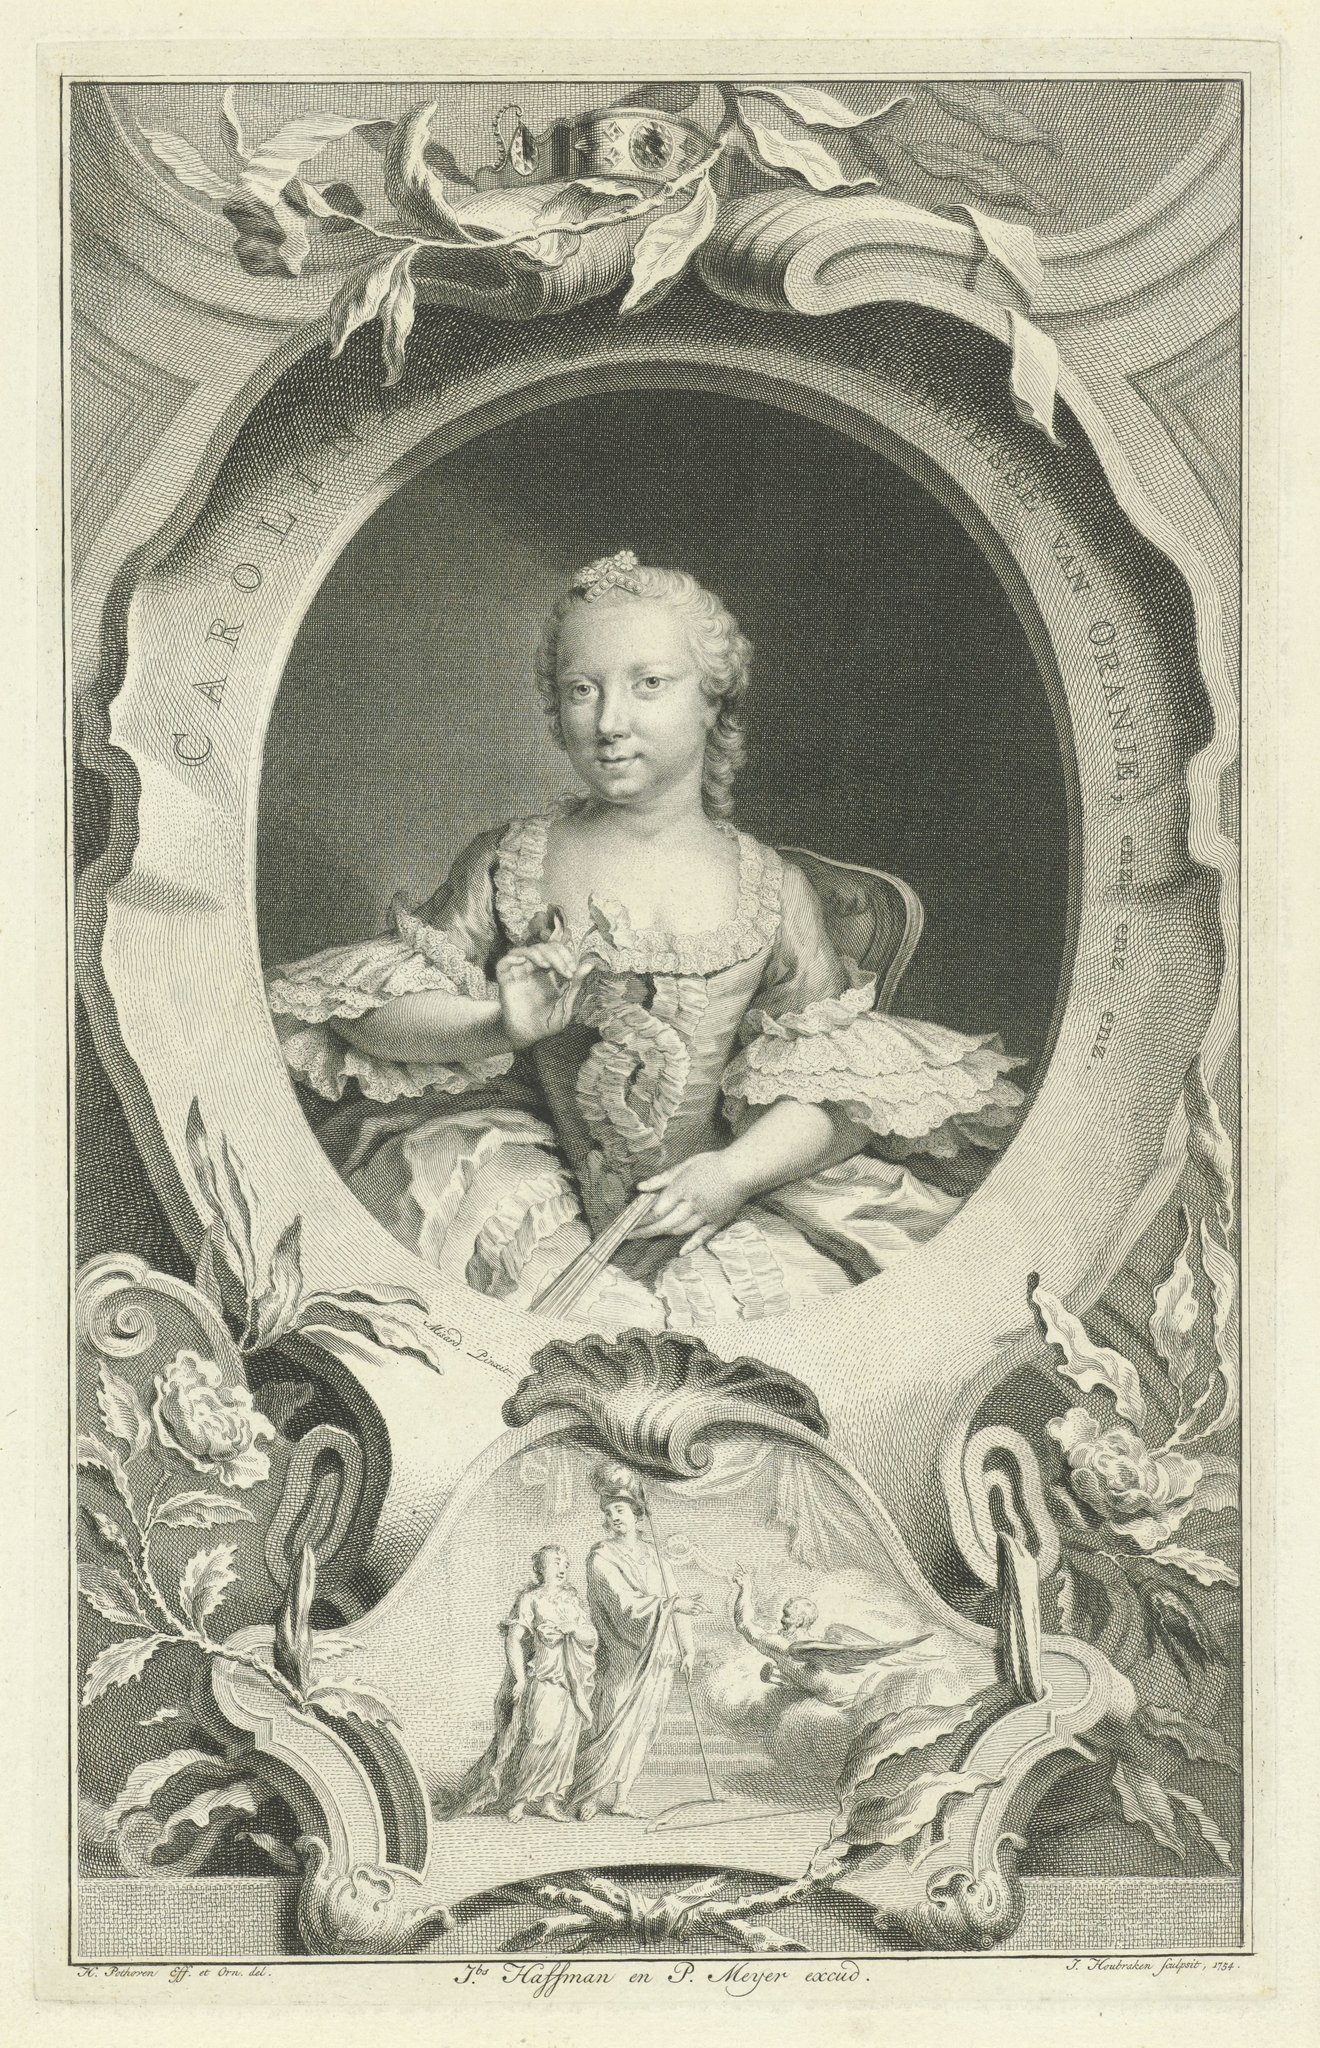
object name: print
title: Portret van Carolina, prinses van Oranje-Nassau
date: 1754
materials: paper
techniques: engraving, etching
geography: amsterdam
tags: carolina (prinses van oranje-nassau)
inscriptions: collector's mark: Lugt 2228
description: Portret van Carolina, prinses van Oranje-Nassau in een ovaal met onder het portret een cartouche waarop een allegorische voorstelling waarin Minerva de jonge Carolina wijst op Vader Tijd.